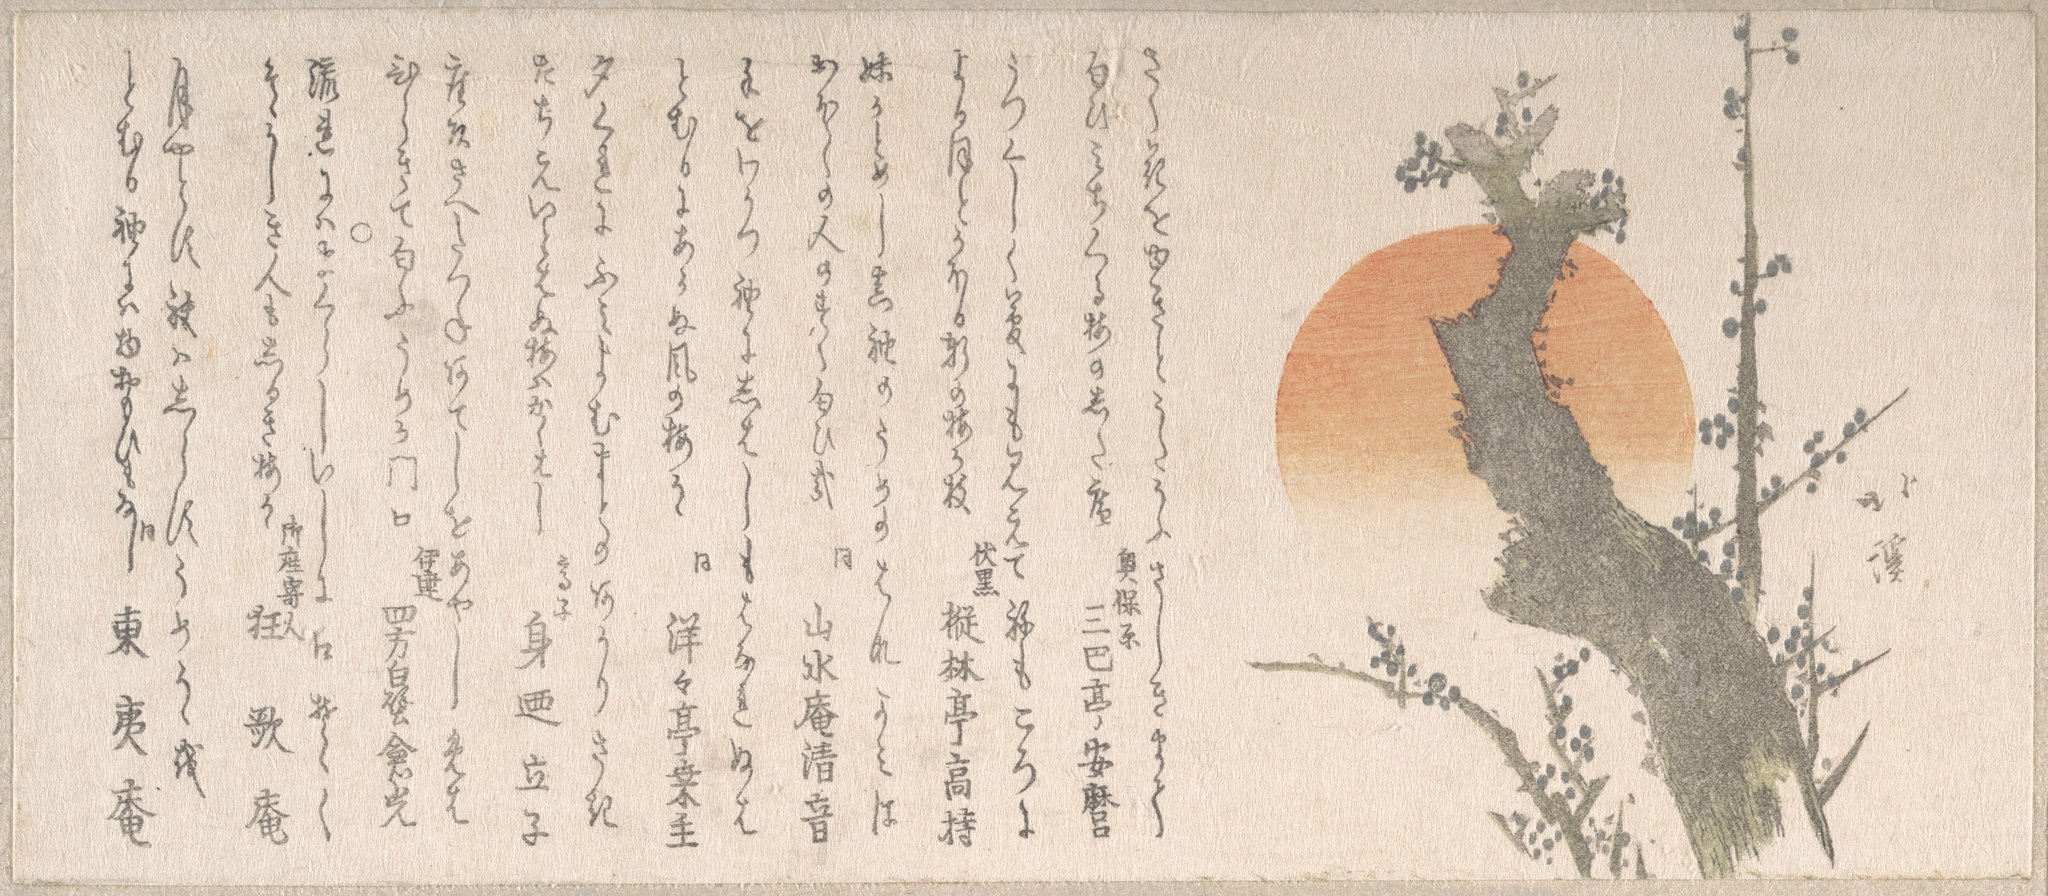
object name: print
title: Rising Sun and Plum Tree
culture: japanese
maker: totoya hokkei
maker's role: artist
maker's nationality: japanese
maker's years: 1780-1850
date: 1801-1900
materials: ink, paper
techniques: surimono, woodblock print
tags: sun,trees